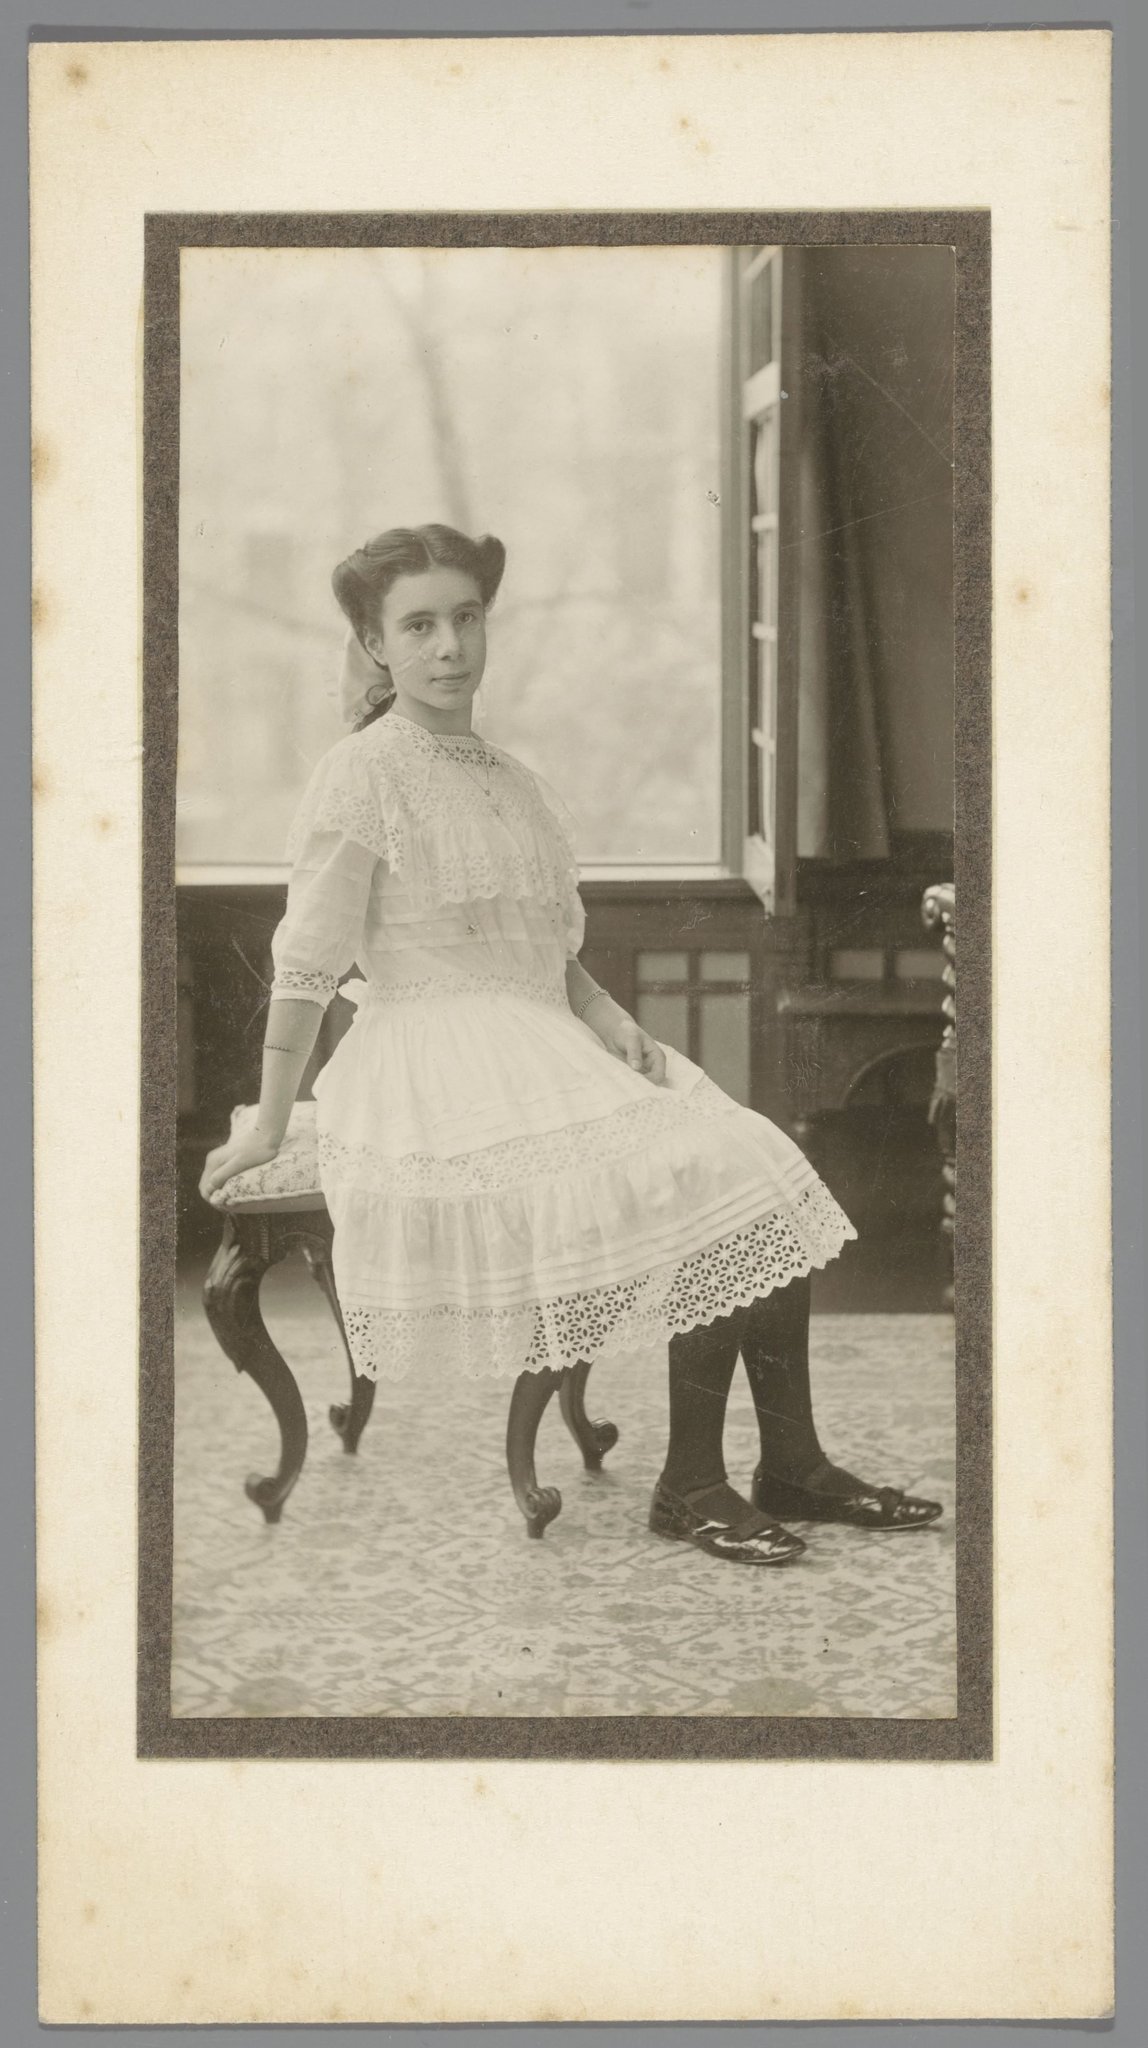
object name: photograph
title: Portret van een onbekend meisje in een kanten jurk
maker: Anonymous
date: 1900-1920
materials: paper, cardboard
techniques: gelatin silver print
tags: anonymous historical person portrayed - bb - woman